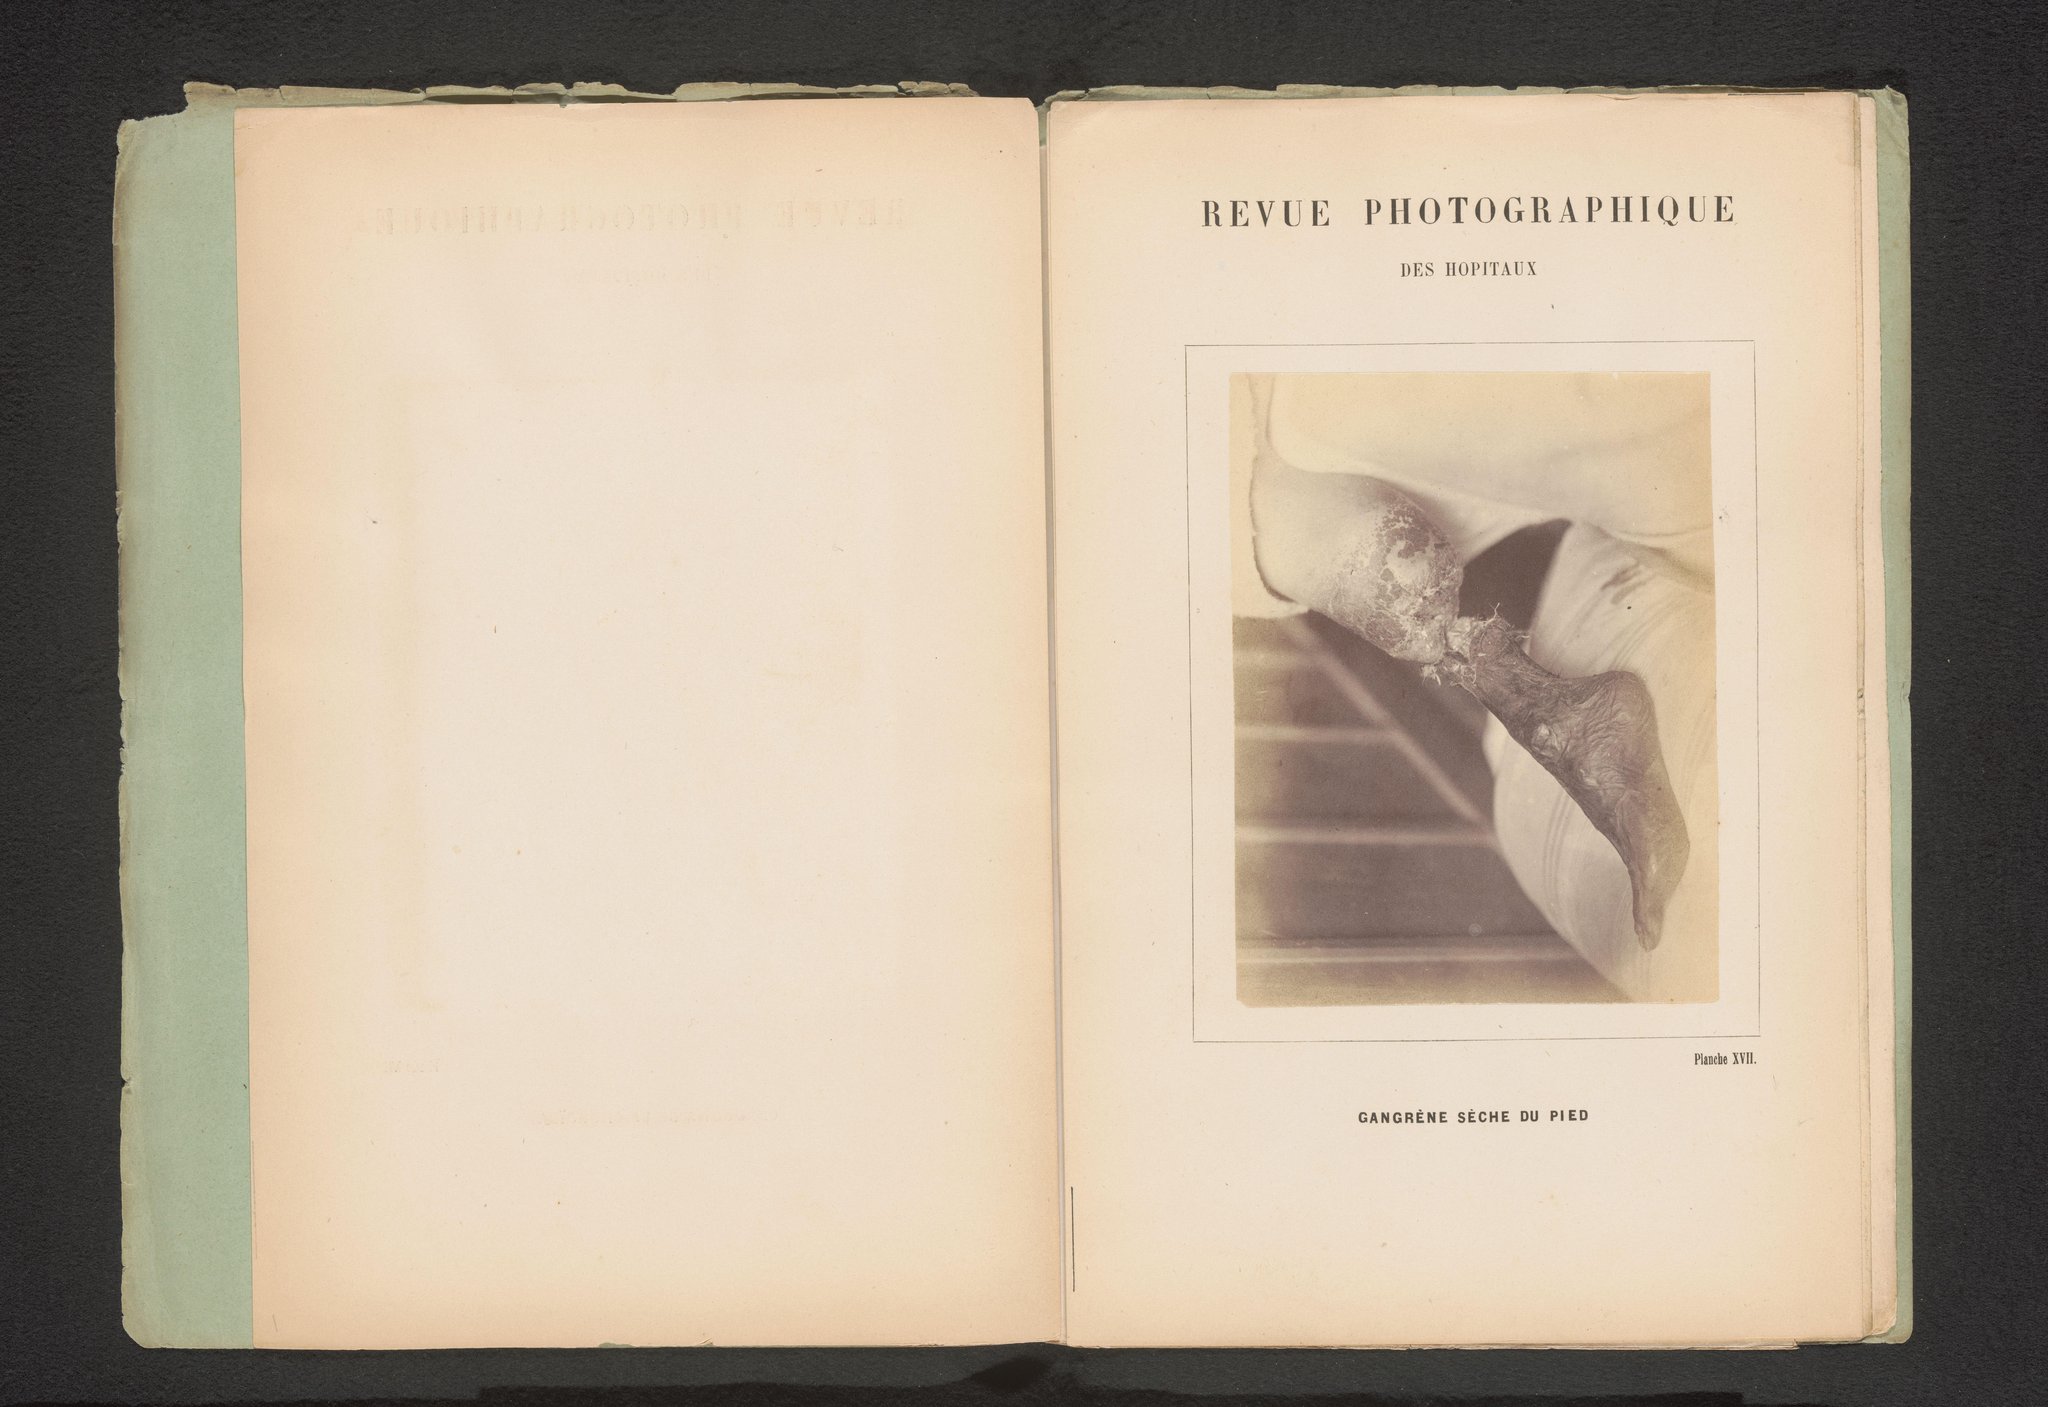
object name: photograph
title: Gezicht op een voet met droog gangreen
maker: Anonymous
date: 1865-1870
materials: paper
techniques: albumen print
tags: skin and venereal diseases, foot, medical research, branches of medicine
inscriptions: inscription: ‘Revue photographique/ des hopitaux/ Planche XVII.’